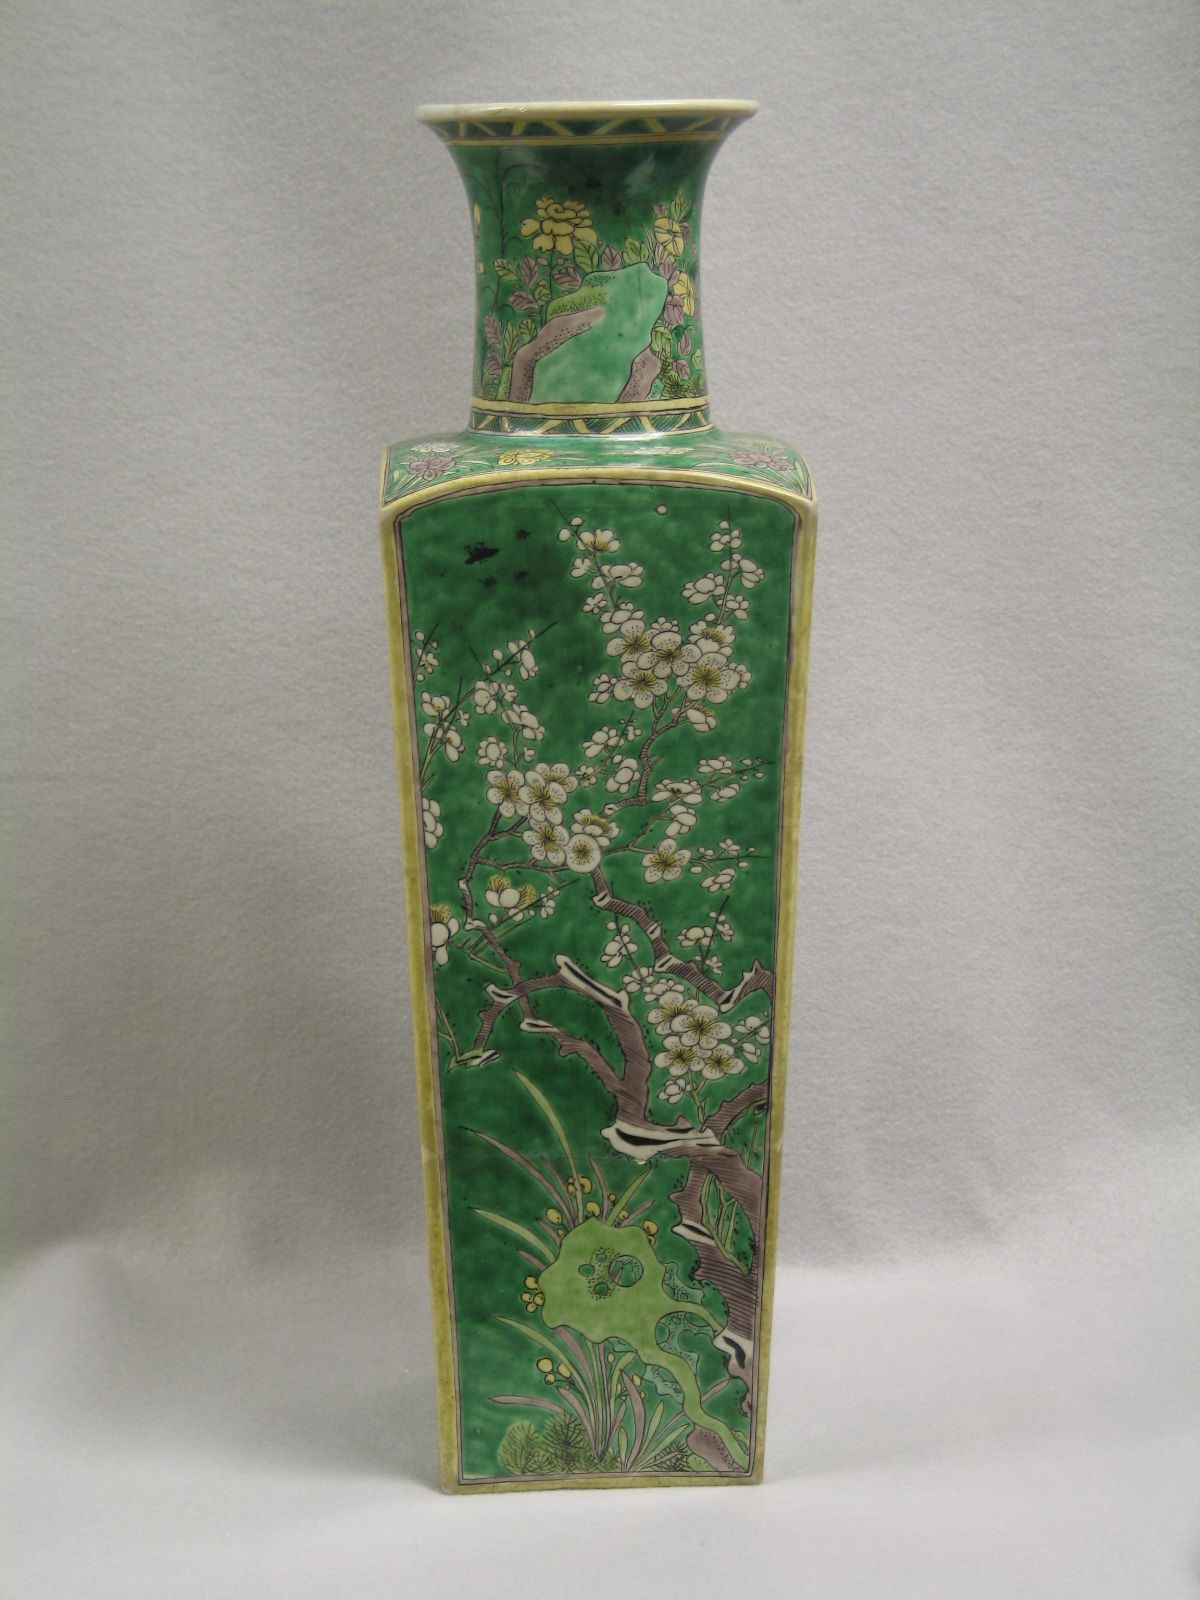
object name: vase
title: Vase (one of a pair)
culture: chinese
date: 1644-1911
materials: enamel, porcelain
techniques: overglaze, painting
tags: flowers